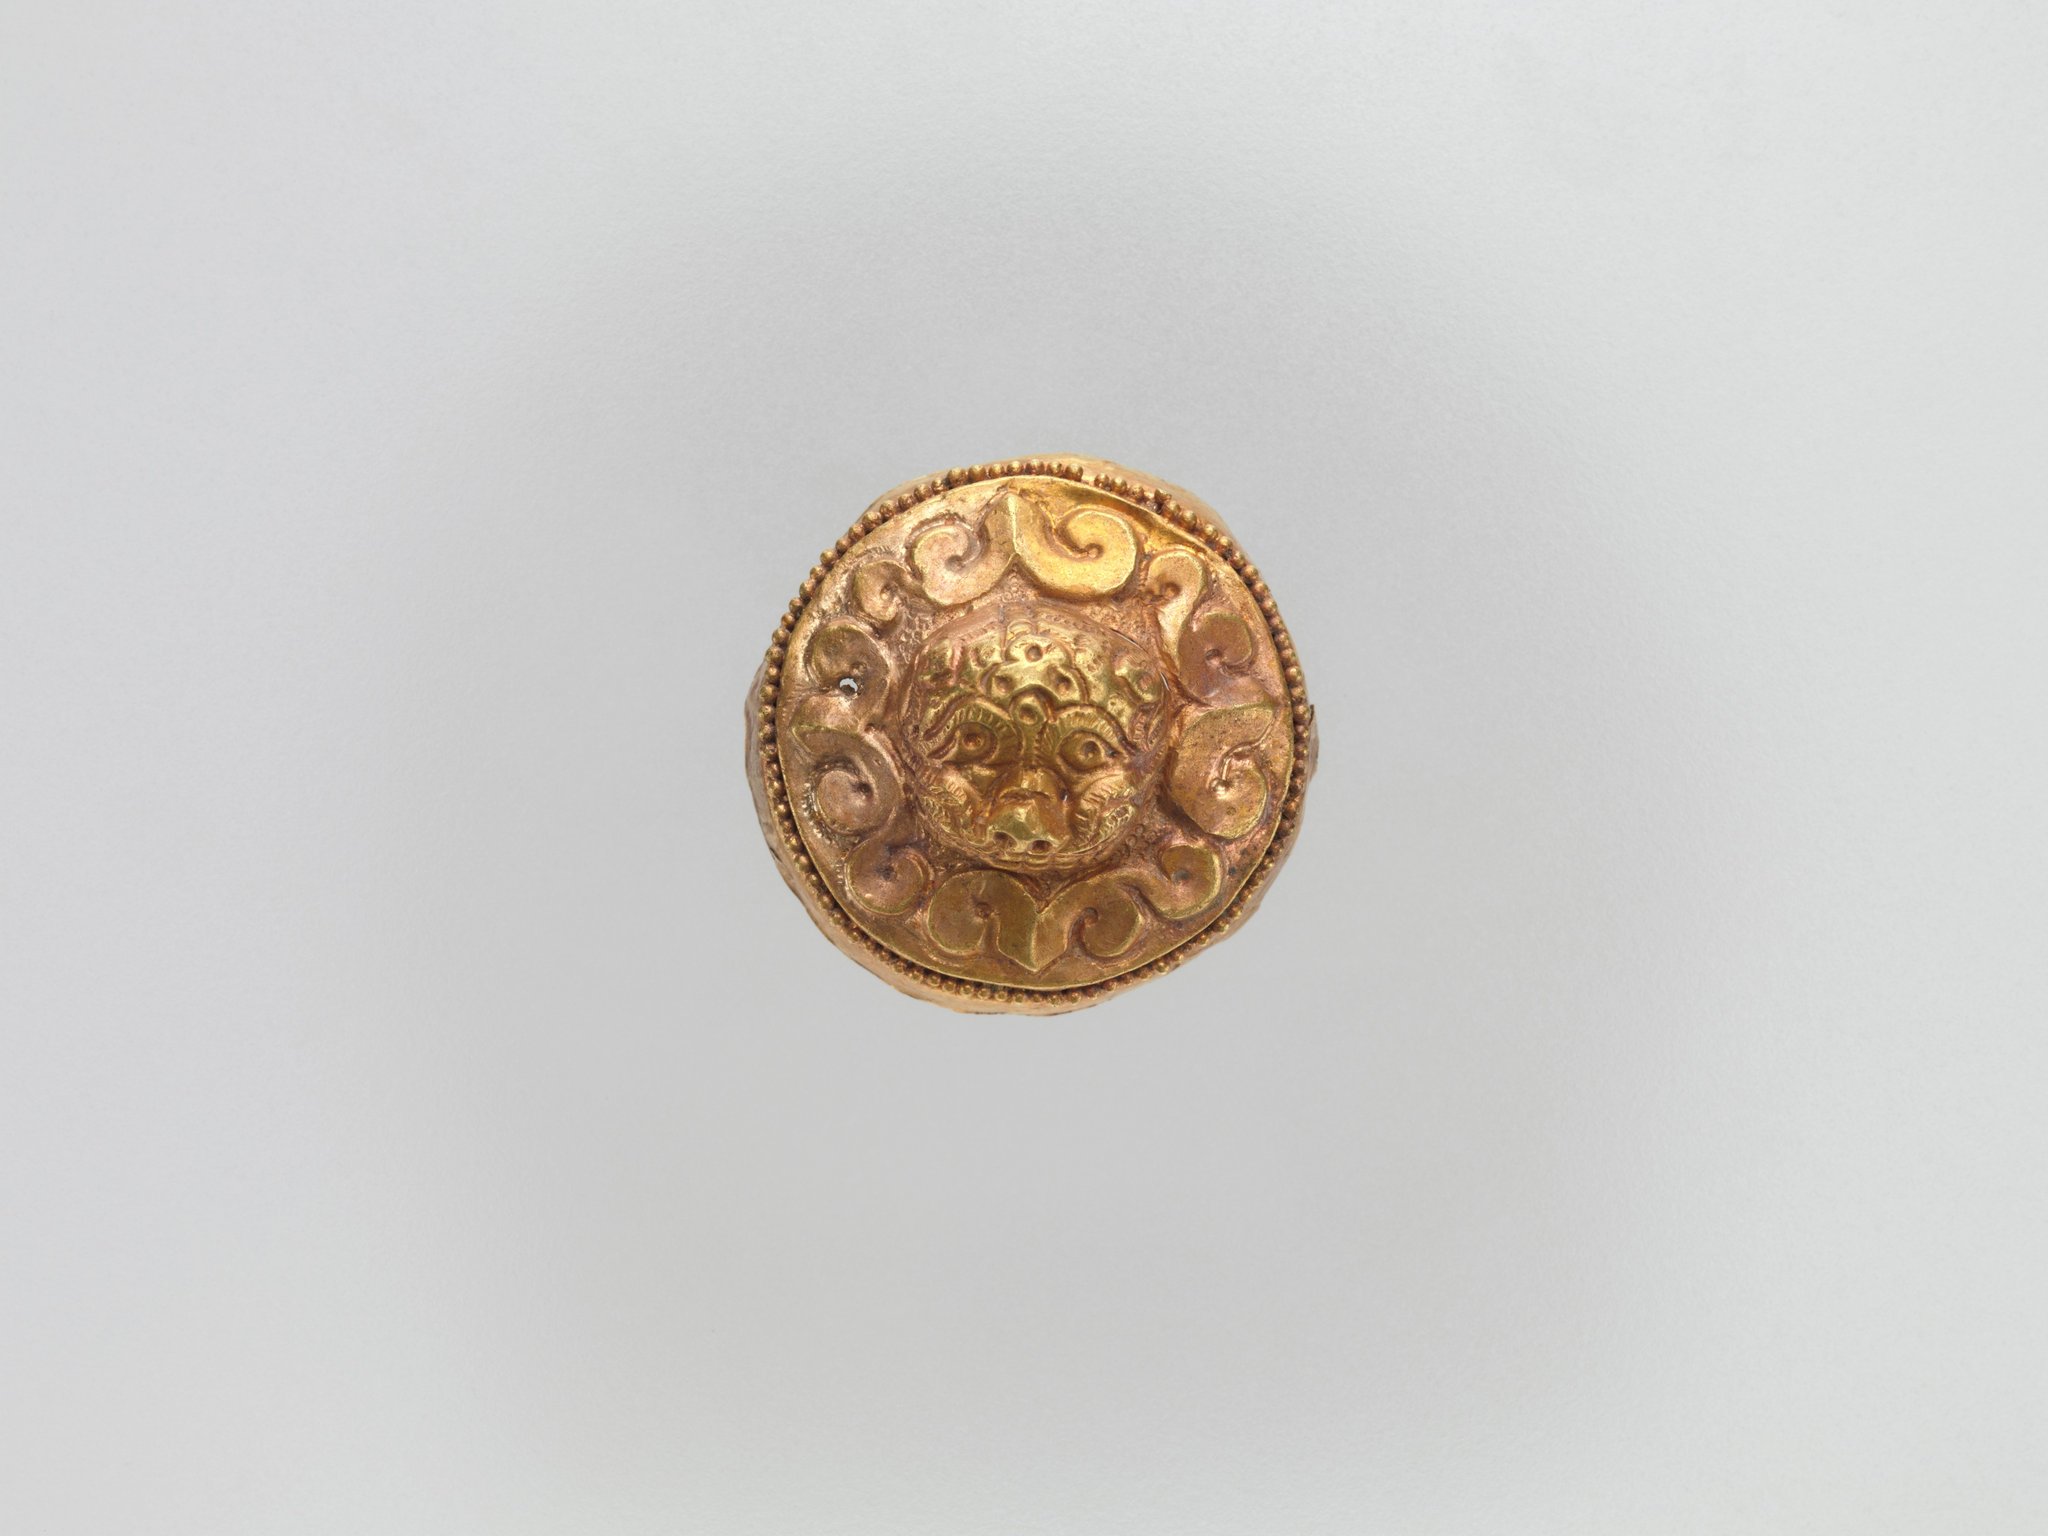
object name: plaque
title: Cap-Shaped Plaque with Lion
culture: chinese or central asian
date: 601-900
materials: gold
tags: lions